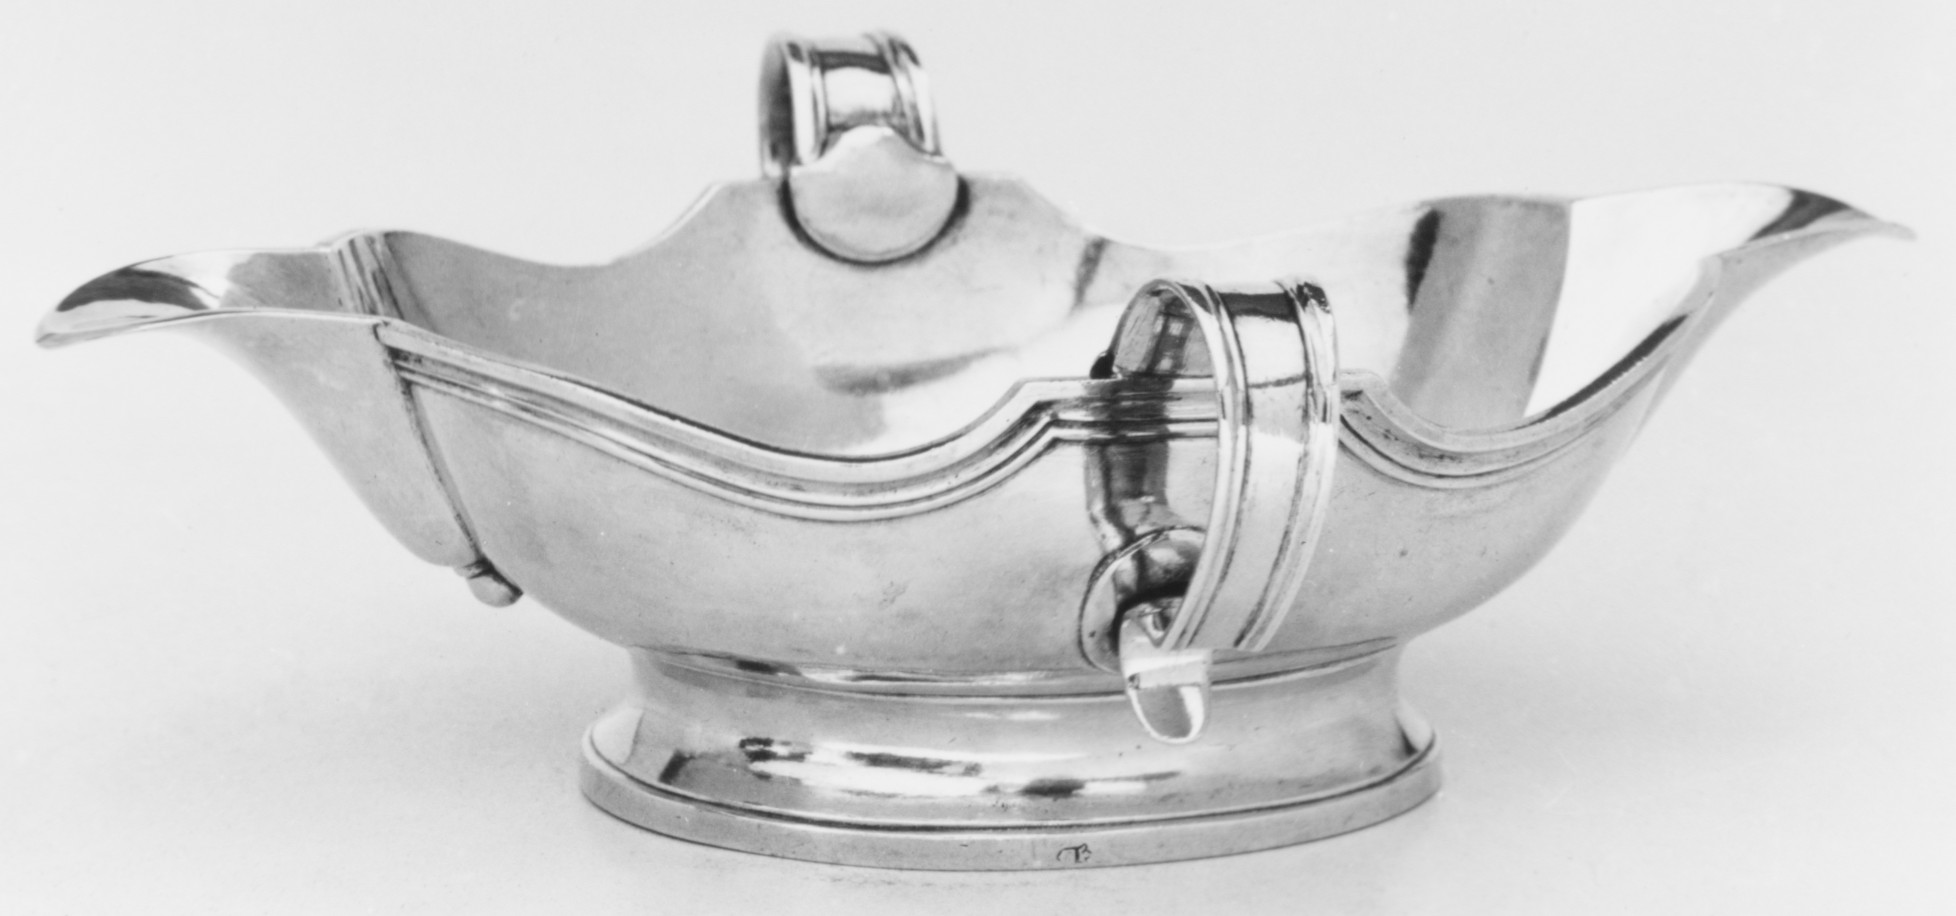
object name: sauceboat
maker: jean-etienne freboul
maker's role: maker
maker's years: 1699-1791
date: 1737-1738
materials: silver